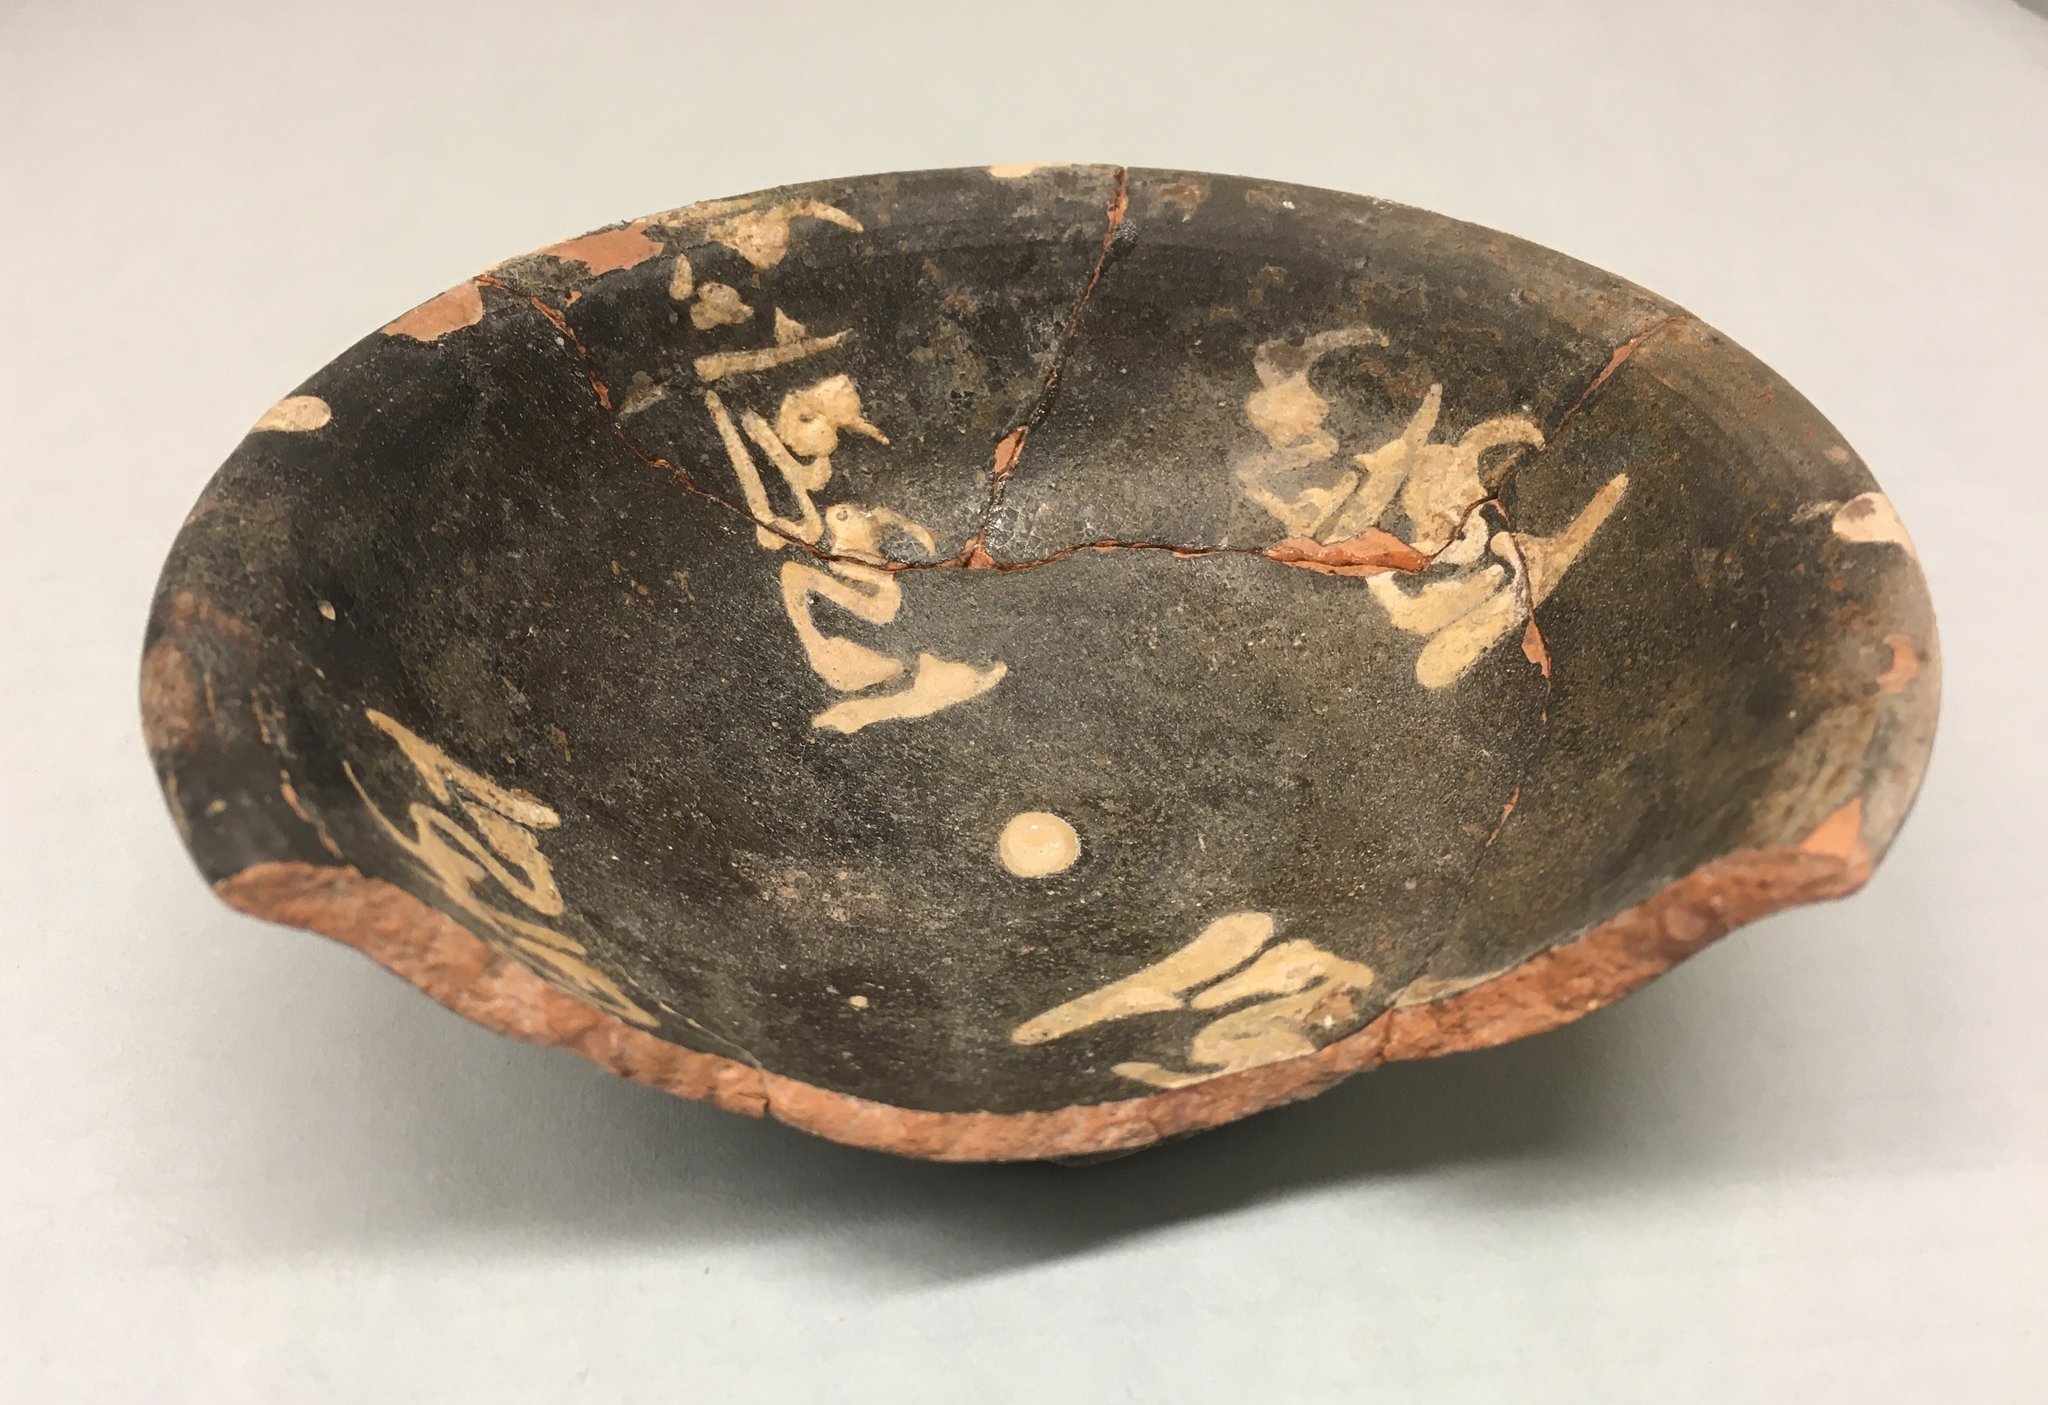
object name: bowl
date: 901-1000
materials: earthenware, glaze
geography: iran